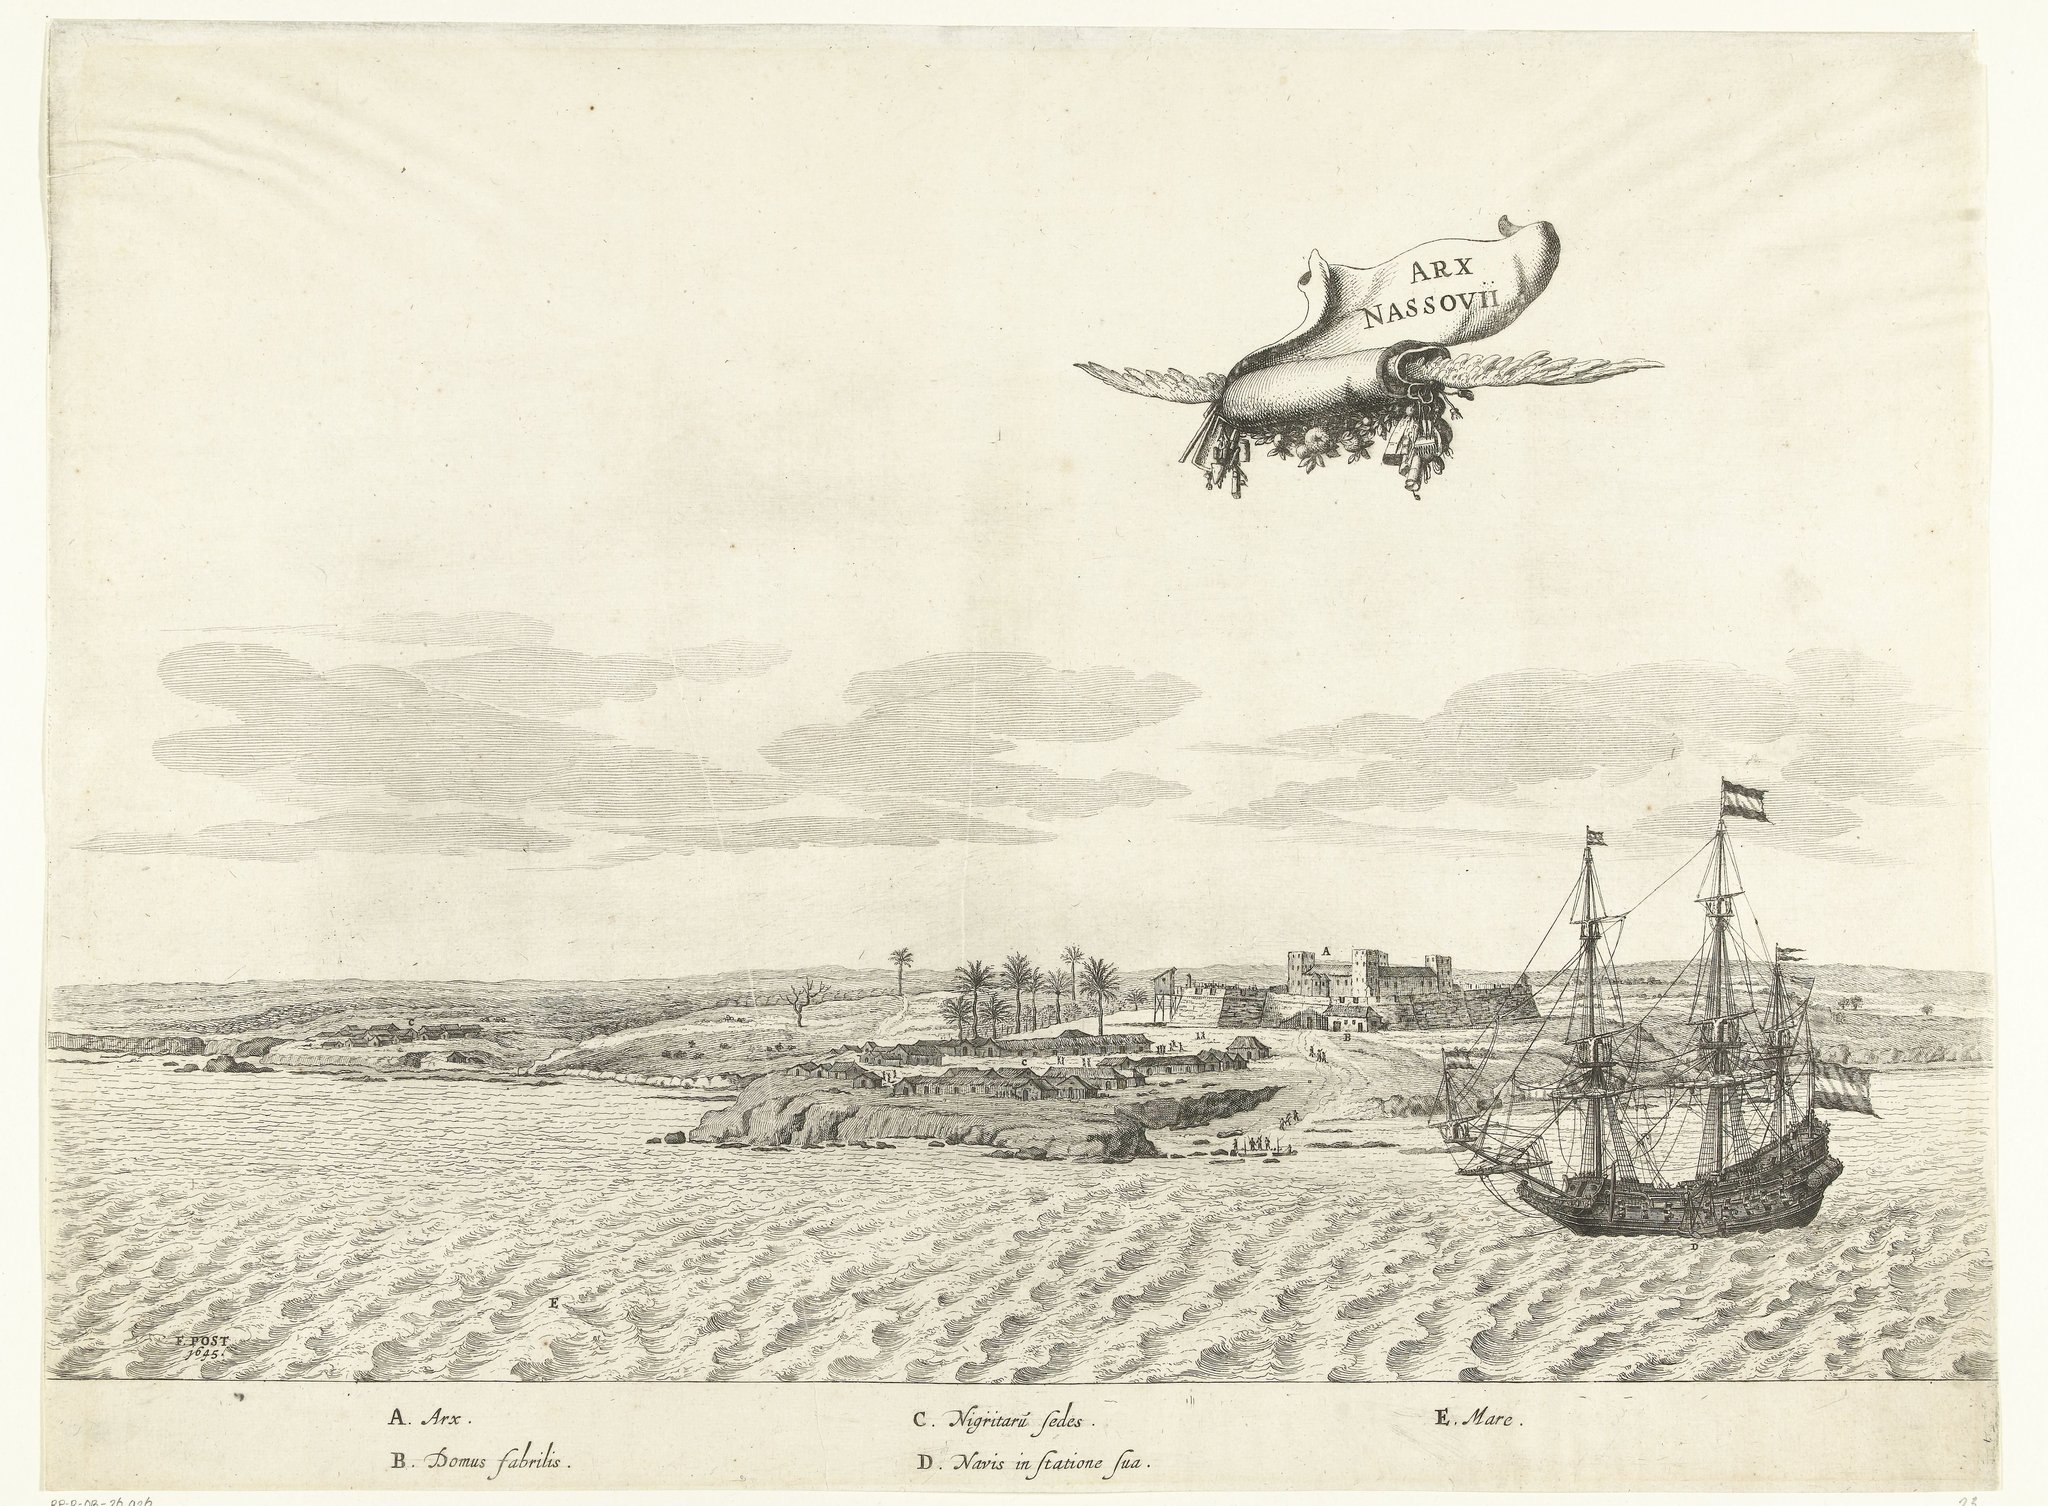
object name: book illustration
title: Arx Nassouii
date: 1645-1647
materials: paper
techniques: engraving, etching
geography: netherlands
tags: earl, johan maurits graaf van nassau-siegen, fortress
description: Prent gebruikt voor: Caspar Barlaeus, Rerum per octennium in Brasilia et alibi nuper gestarum sub praefectura J. Mauritii, Nassoviae, c. comitis... historia, Amsterdam, uitgever Joannes Blaeu, 1647, na p. 56, pl. 23